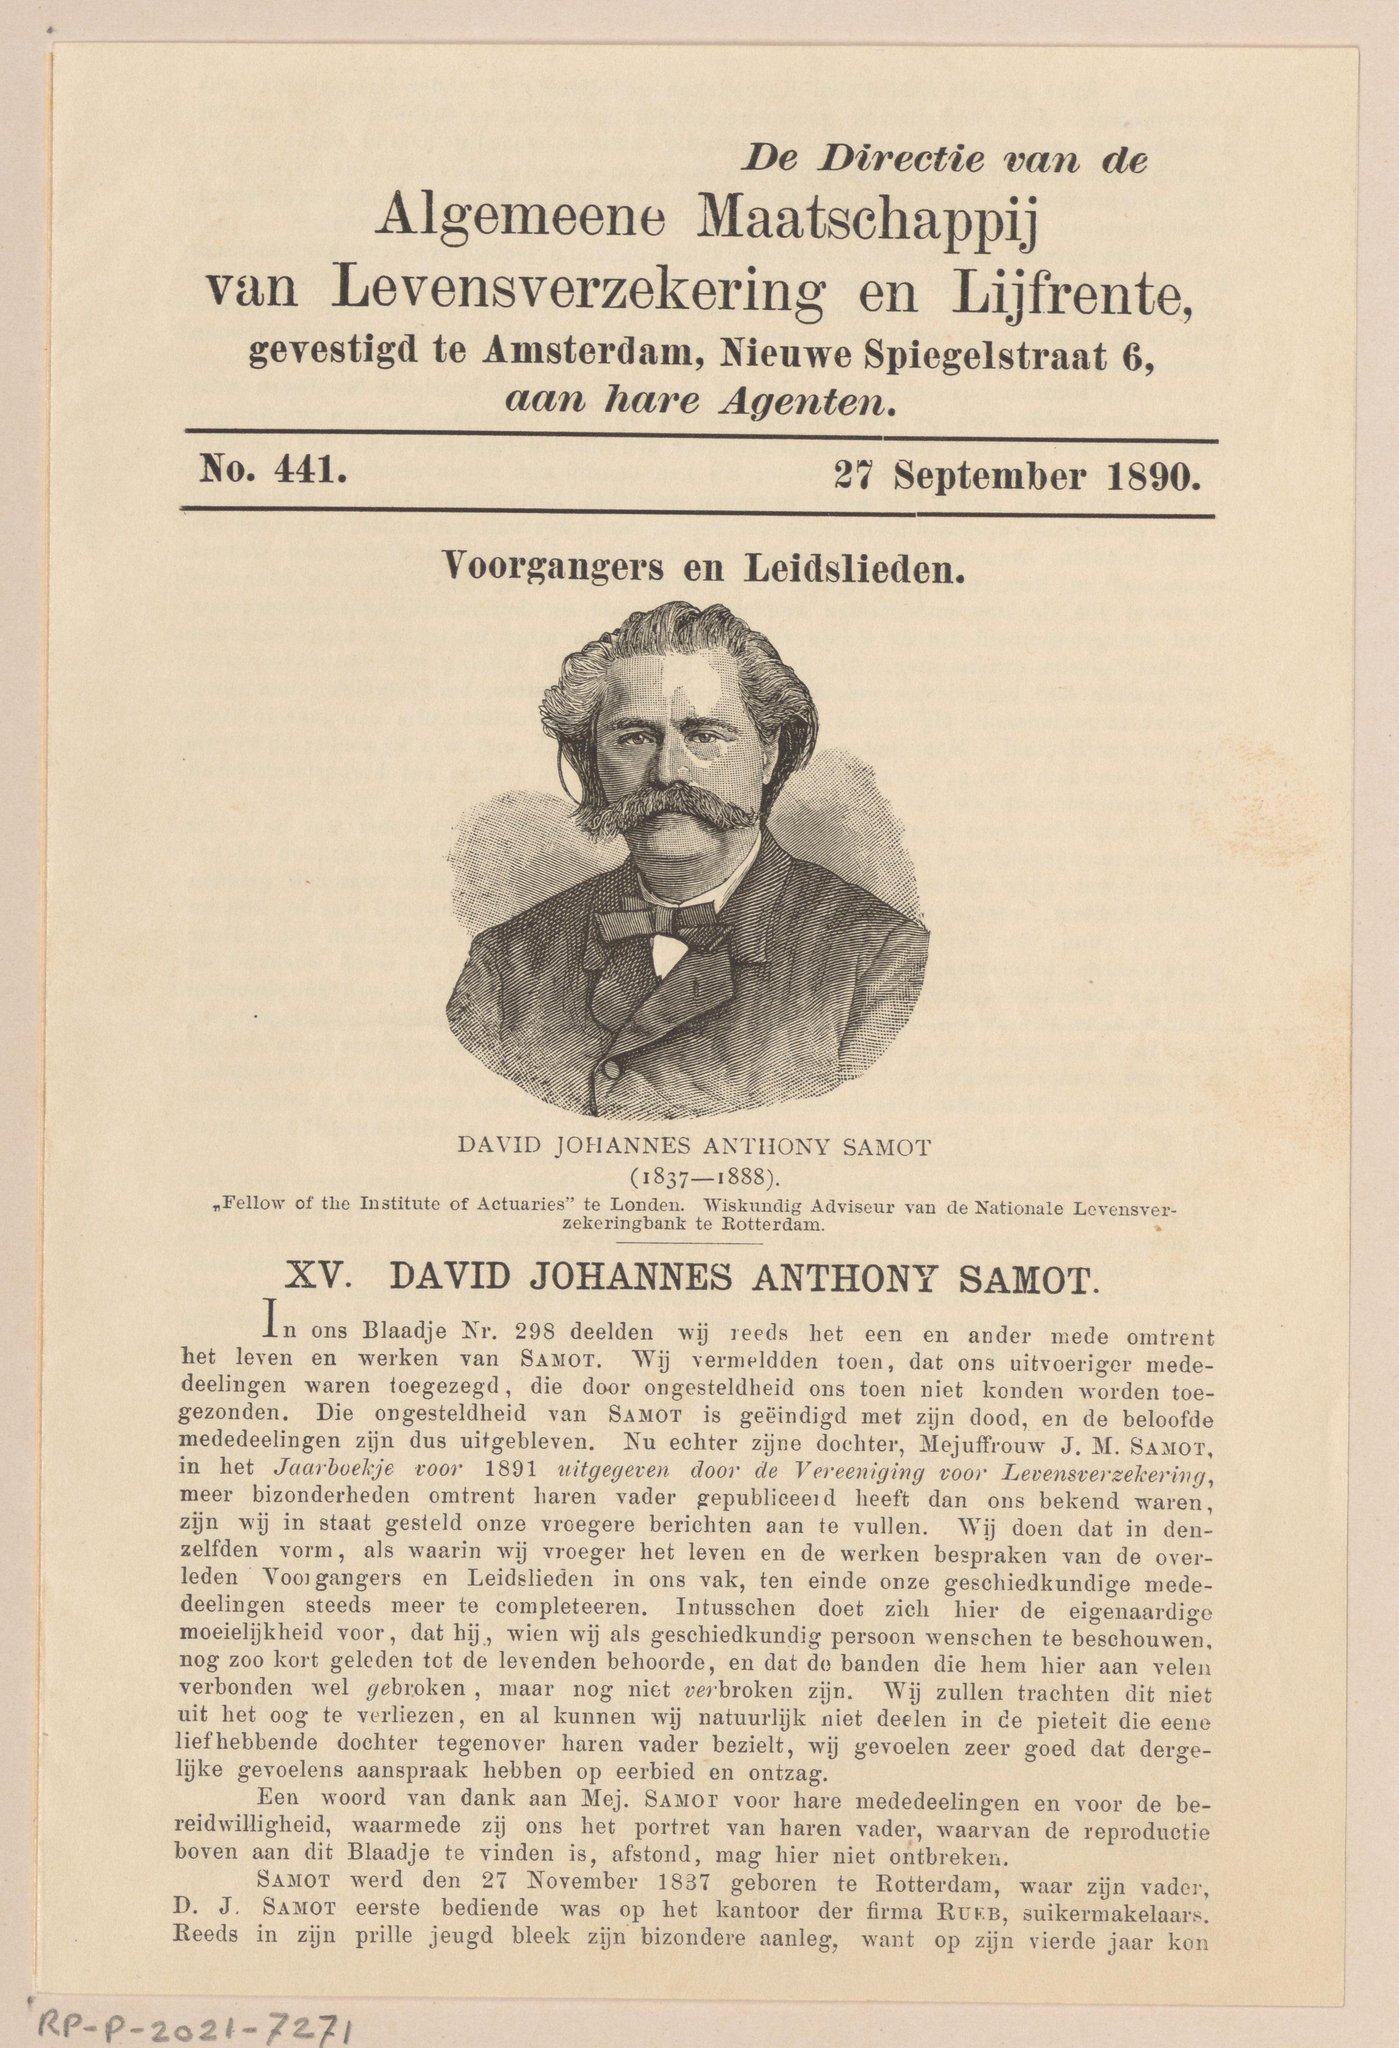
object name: print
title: Portret van David Johannes Anthony Samot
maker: Anonymous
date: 1890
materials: paper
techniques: letterpress printing, engraving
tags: historical persons, mathematics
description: Prent uit: De directie van de Algemeene Maatschappij van Levensverzekering en Lijfrente (...) aan hare agenten, 27 september 1890, nr. 441.